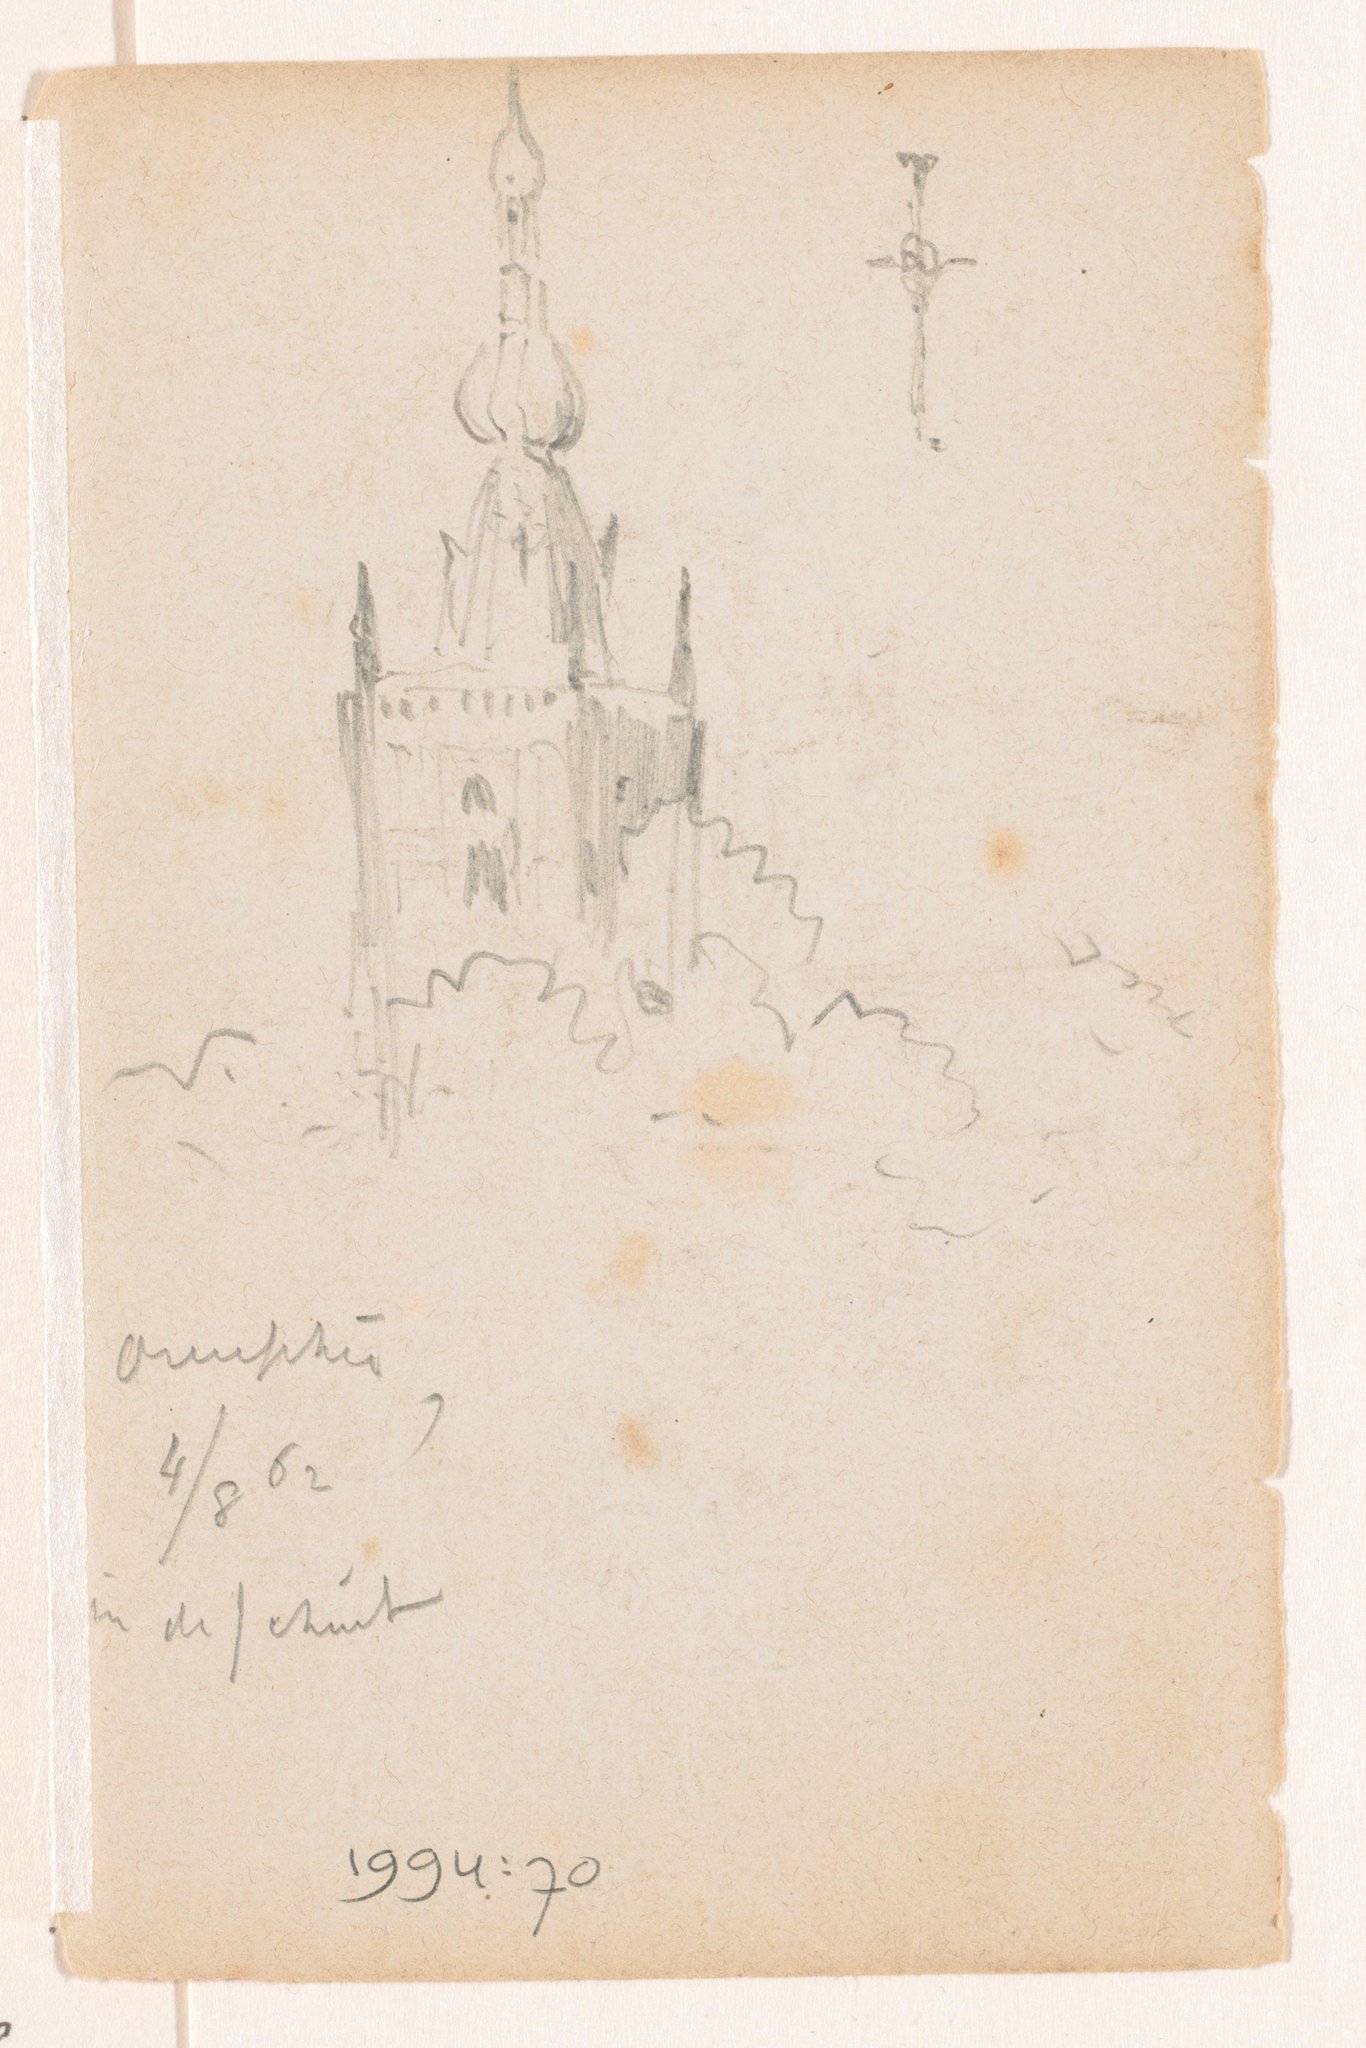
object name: drawing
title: Toren van Overschie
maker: johannes tavenraat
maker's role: draughtsman, painter, print maker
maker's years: 1809-1881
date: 1862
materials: paper, pencil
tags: overschie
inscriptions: date and inscription: ‘Overschie / 4/8 62 / in de schuit’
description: Toren van de Nederlands Hervormde Kerk van Overschie.